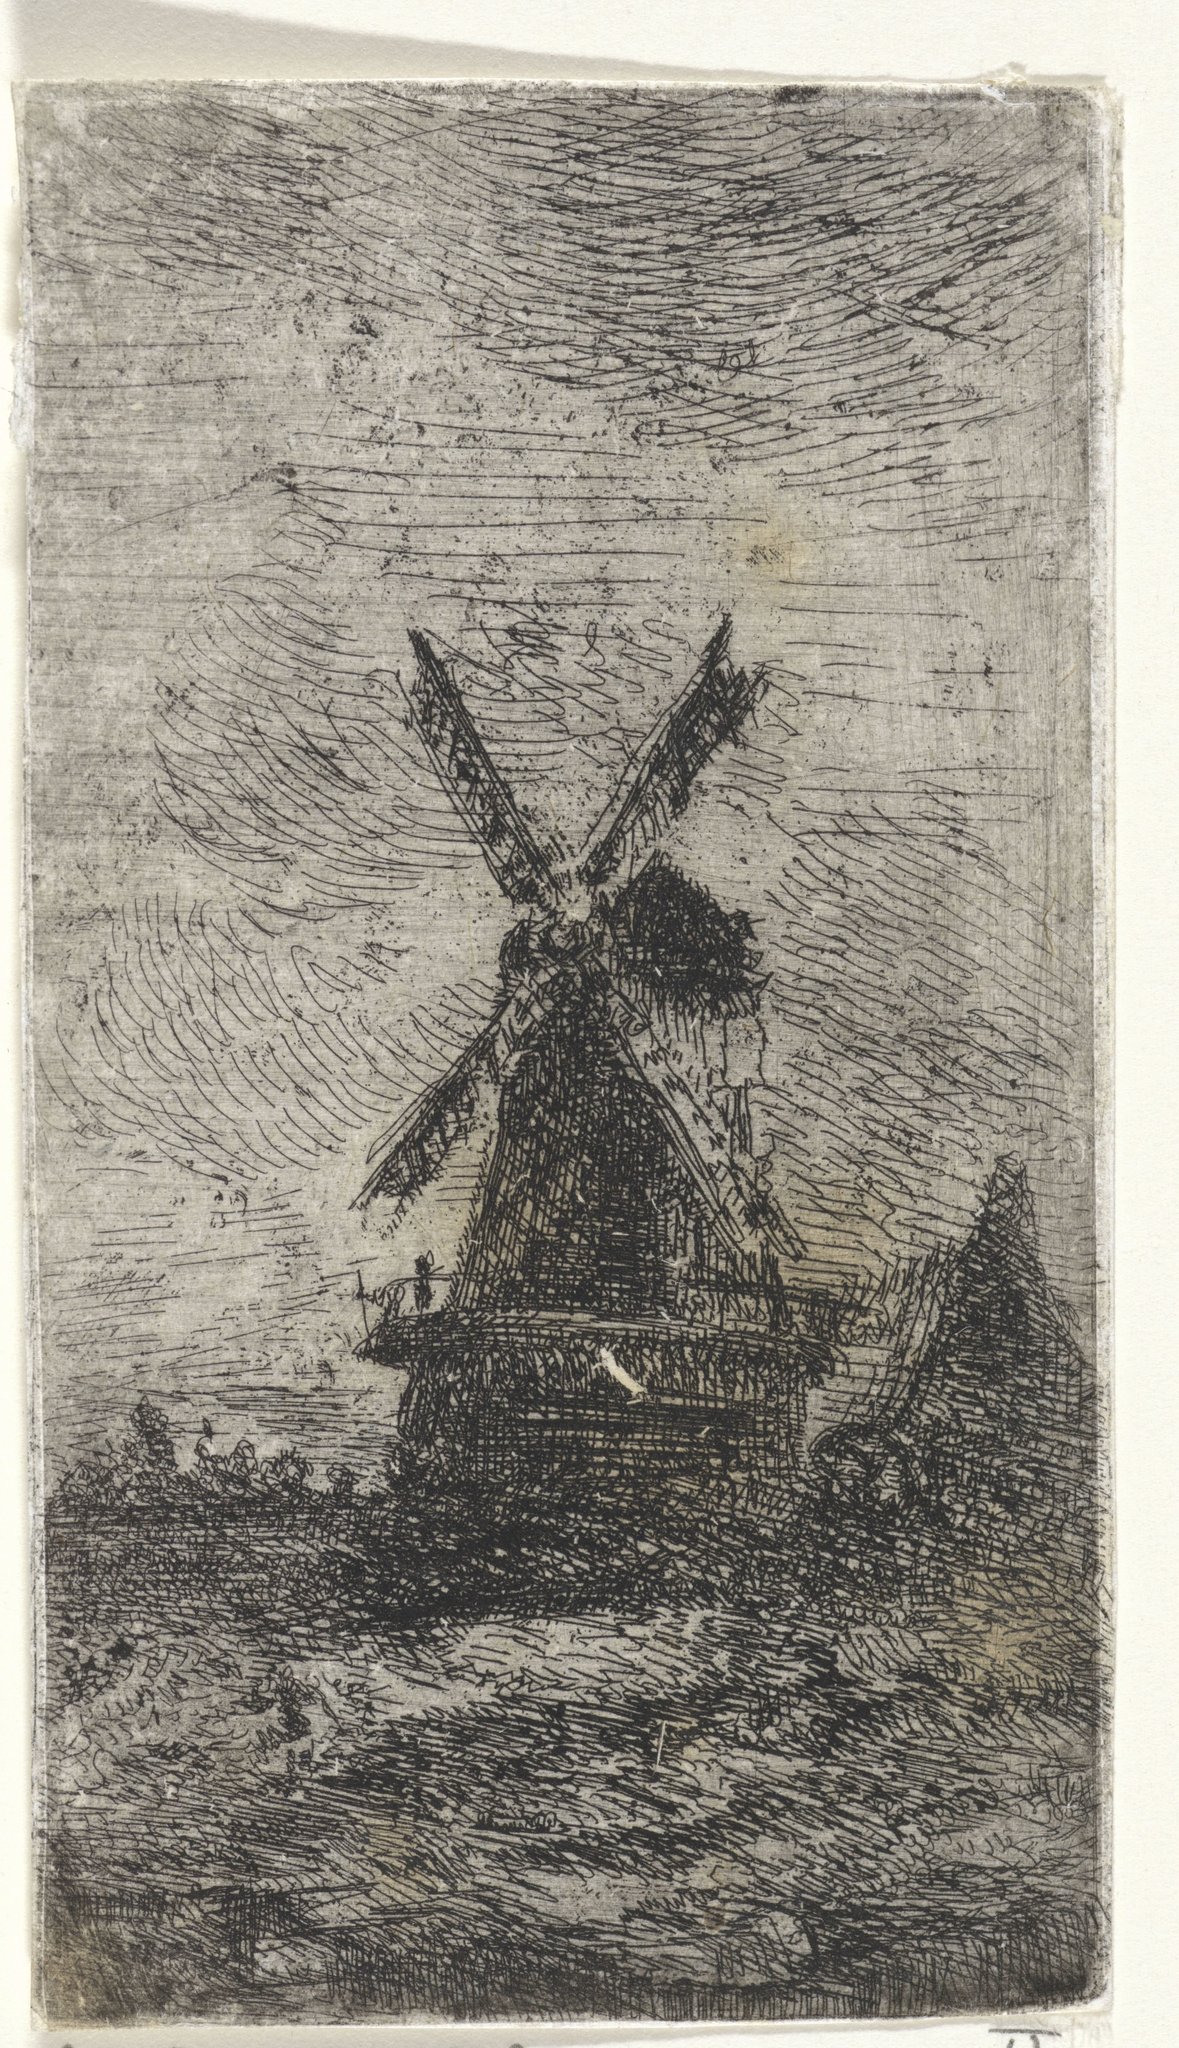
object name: print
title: Windmolen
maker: arnoud schaepkens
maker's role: print maker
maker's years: 1816-1904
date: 1831-1904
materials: paper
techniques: drypoint, etching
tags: windmill in landscape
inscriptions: collector's mark: Lugt 2228